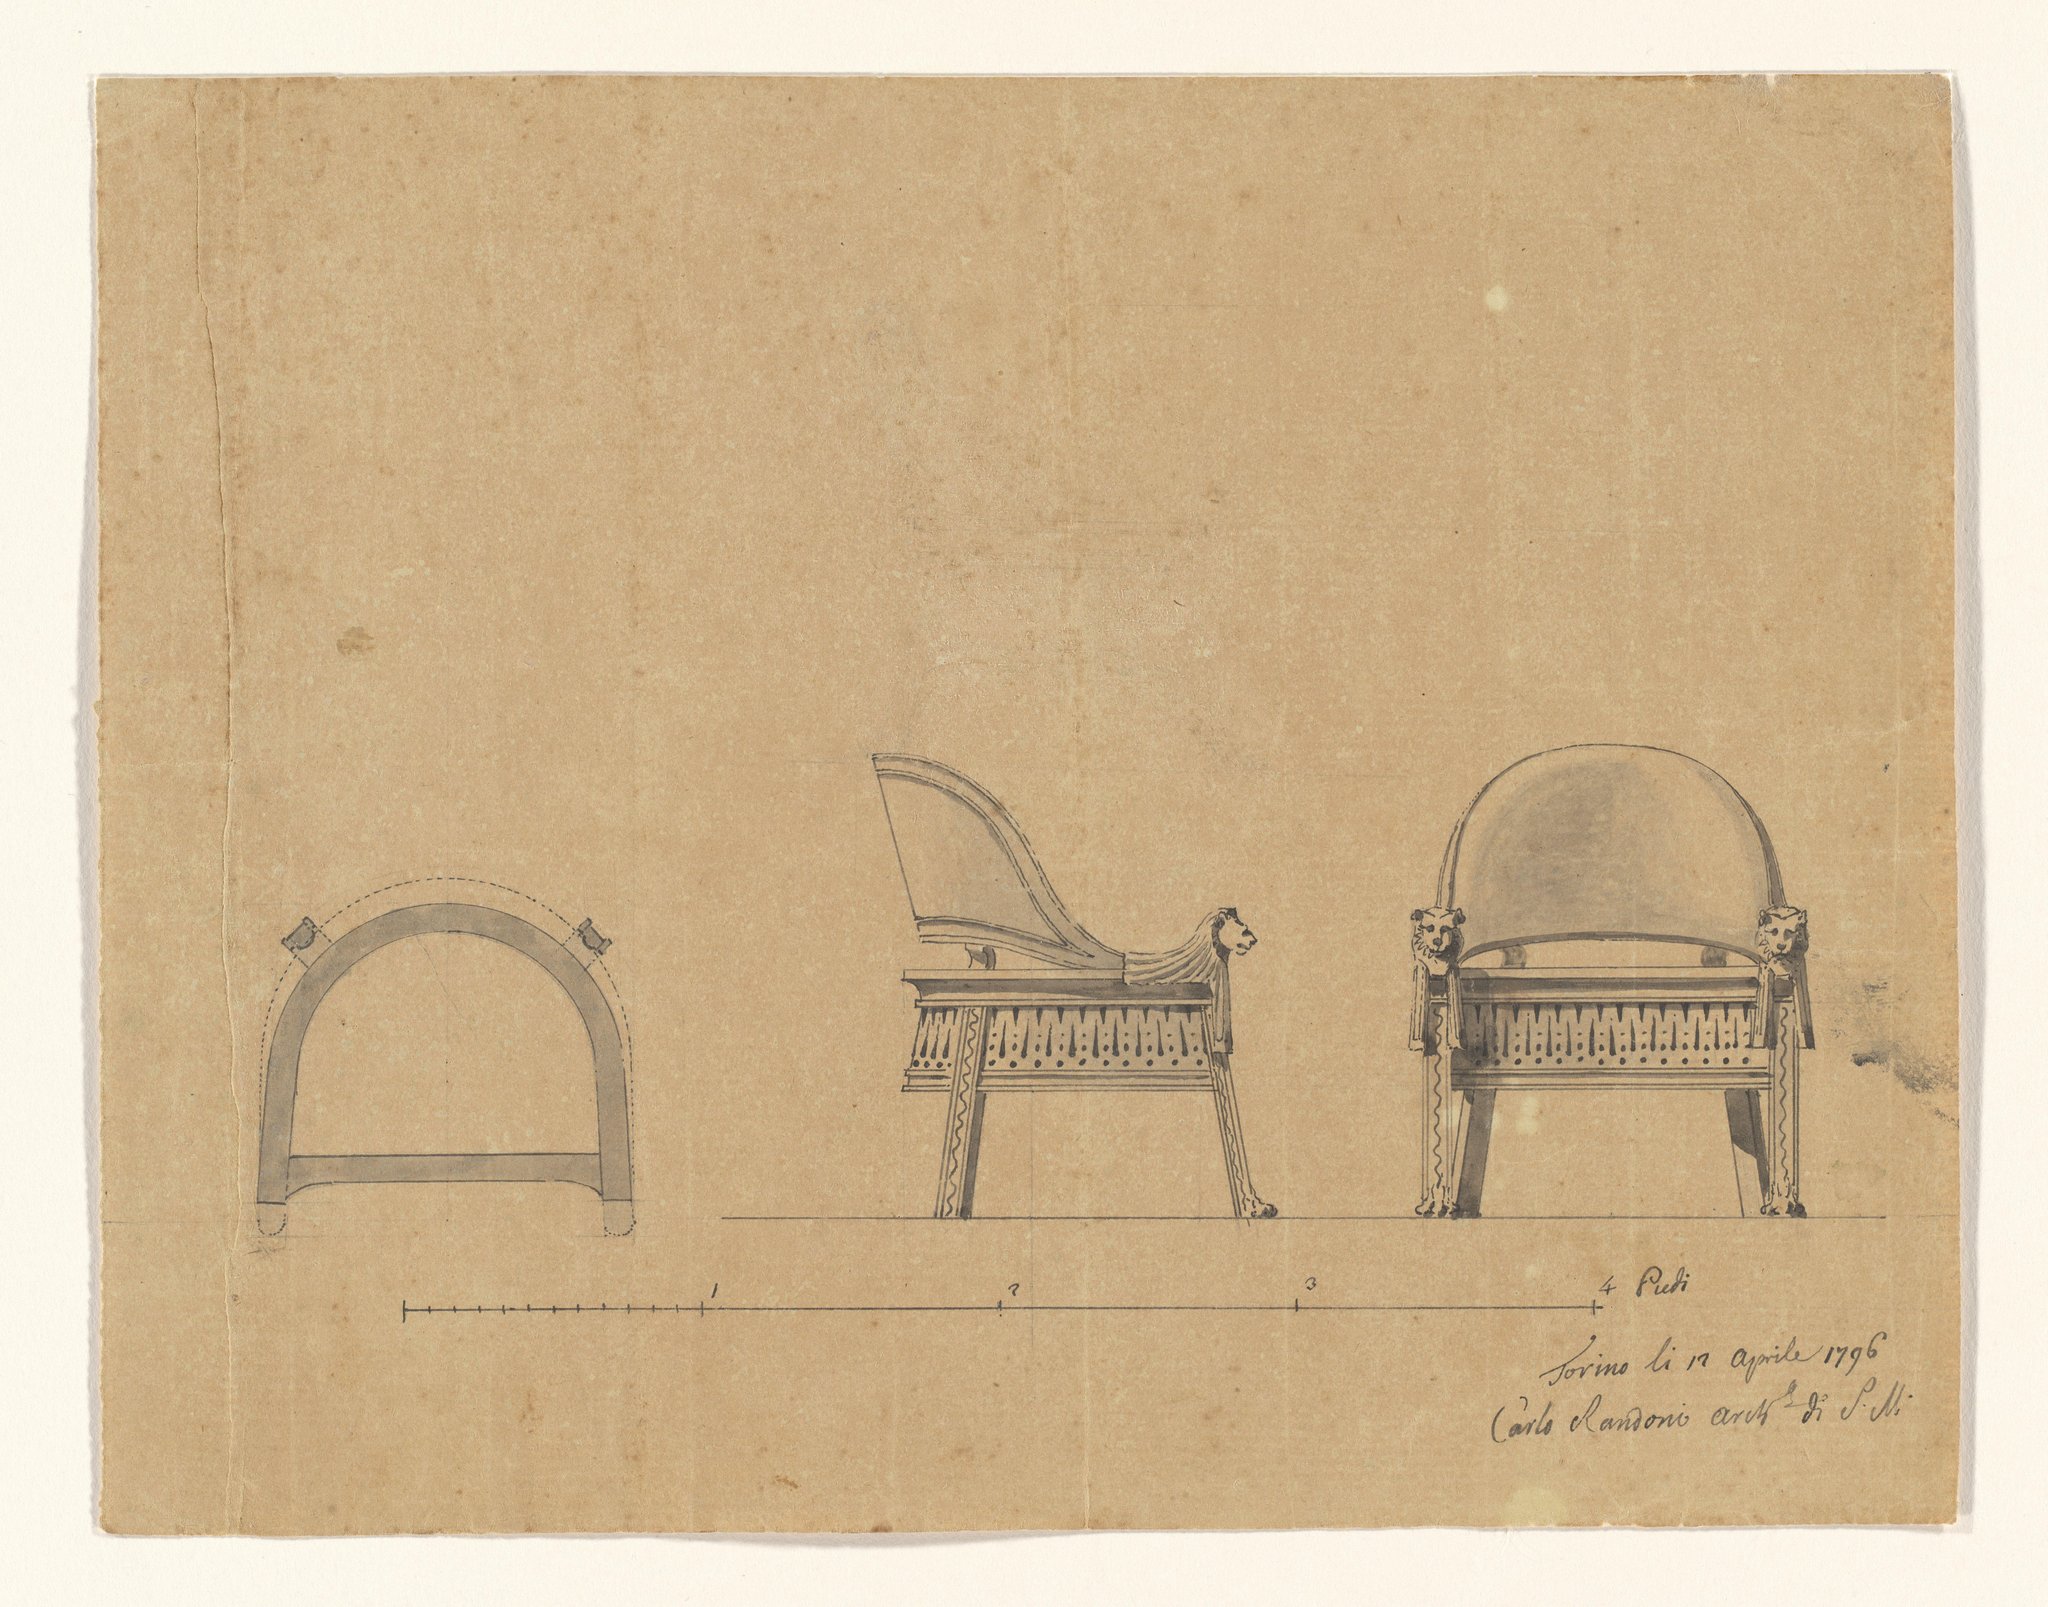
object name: design drawing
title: Ontwerp voor een armstoel in Egyptische stijl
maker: carlo randoni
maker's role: architect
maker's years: 1755-1831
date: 1796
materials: graphite, paper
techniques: brush, pen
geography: turin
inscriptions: collector's mark: ‘Col. / L. BONGARD’, signature and date: ‘Torino li 12 Aprile 1796 / Carlo Randoni arch.o di S.M.’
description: Doorsnede van boven, aanzicht van rechts en van voren.